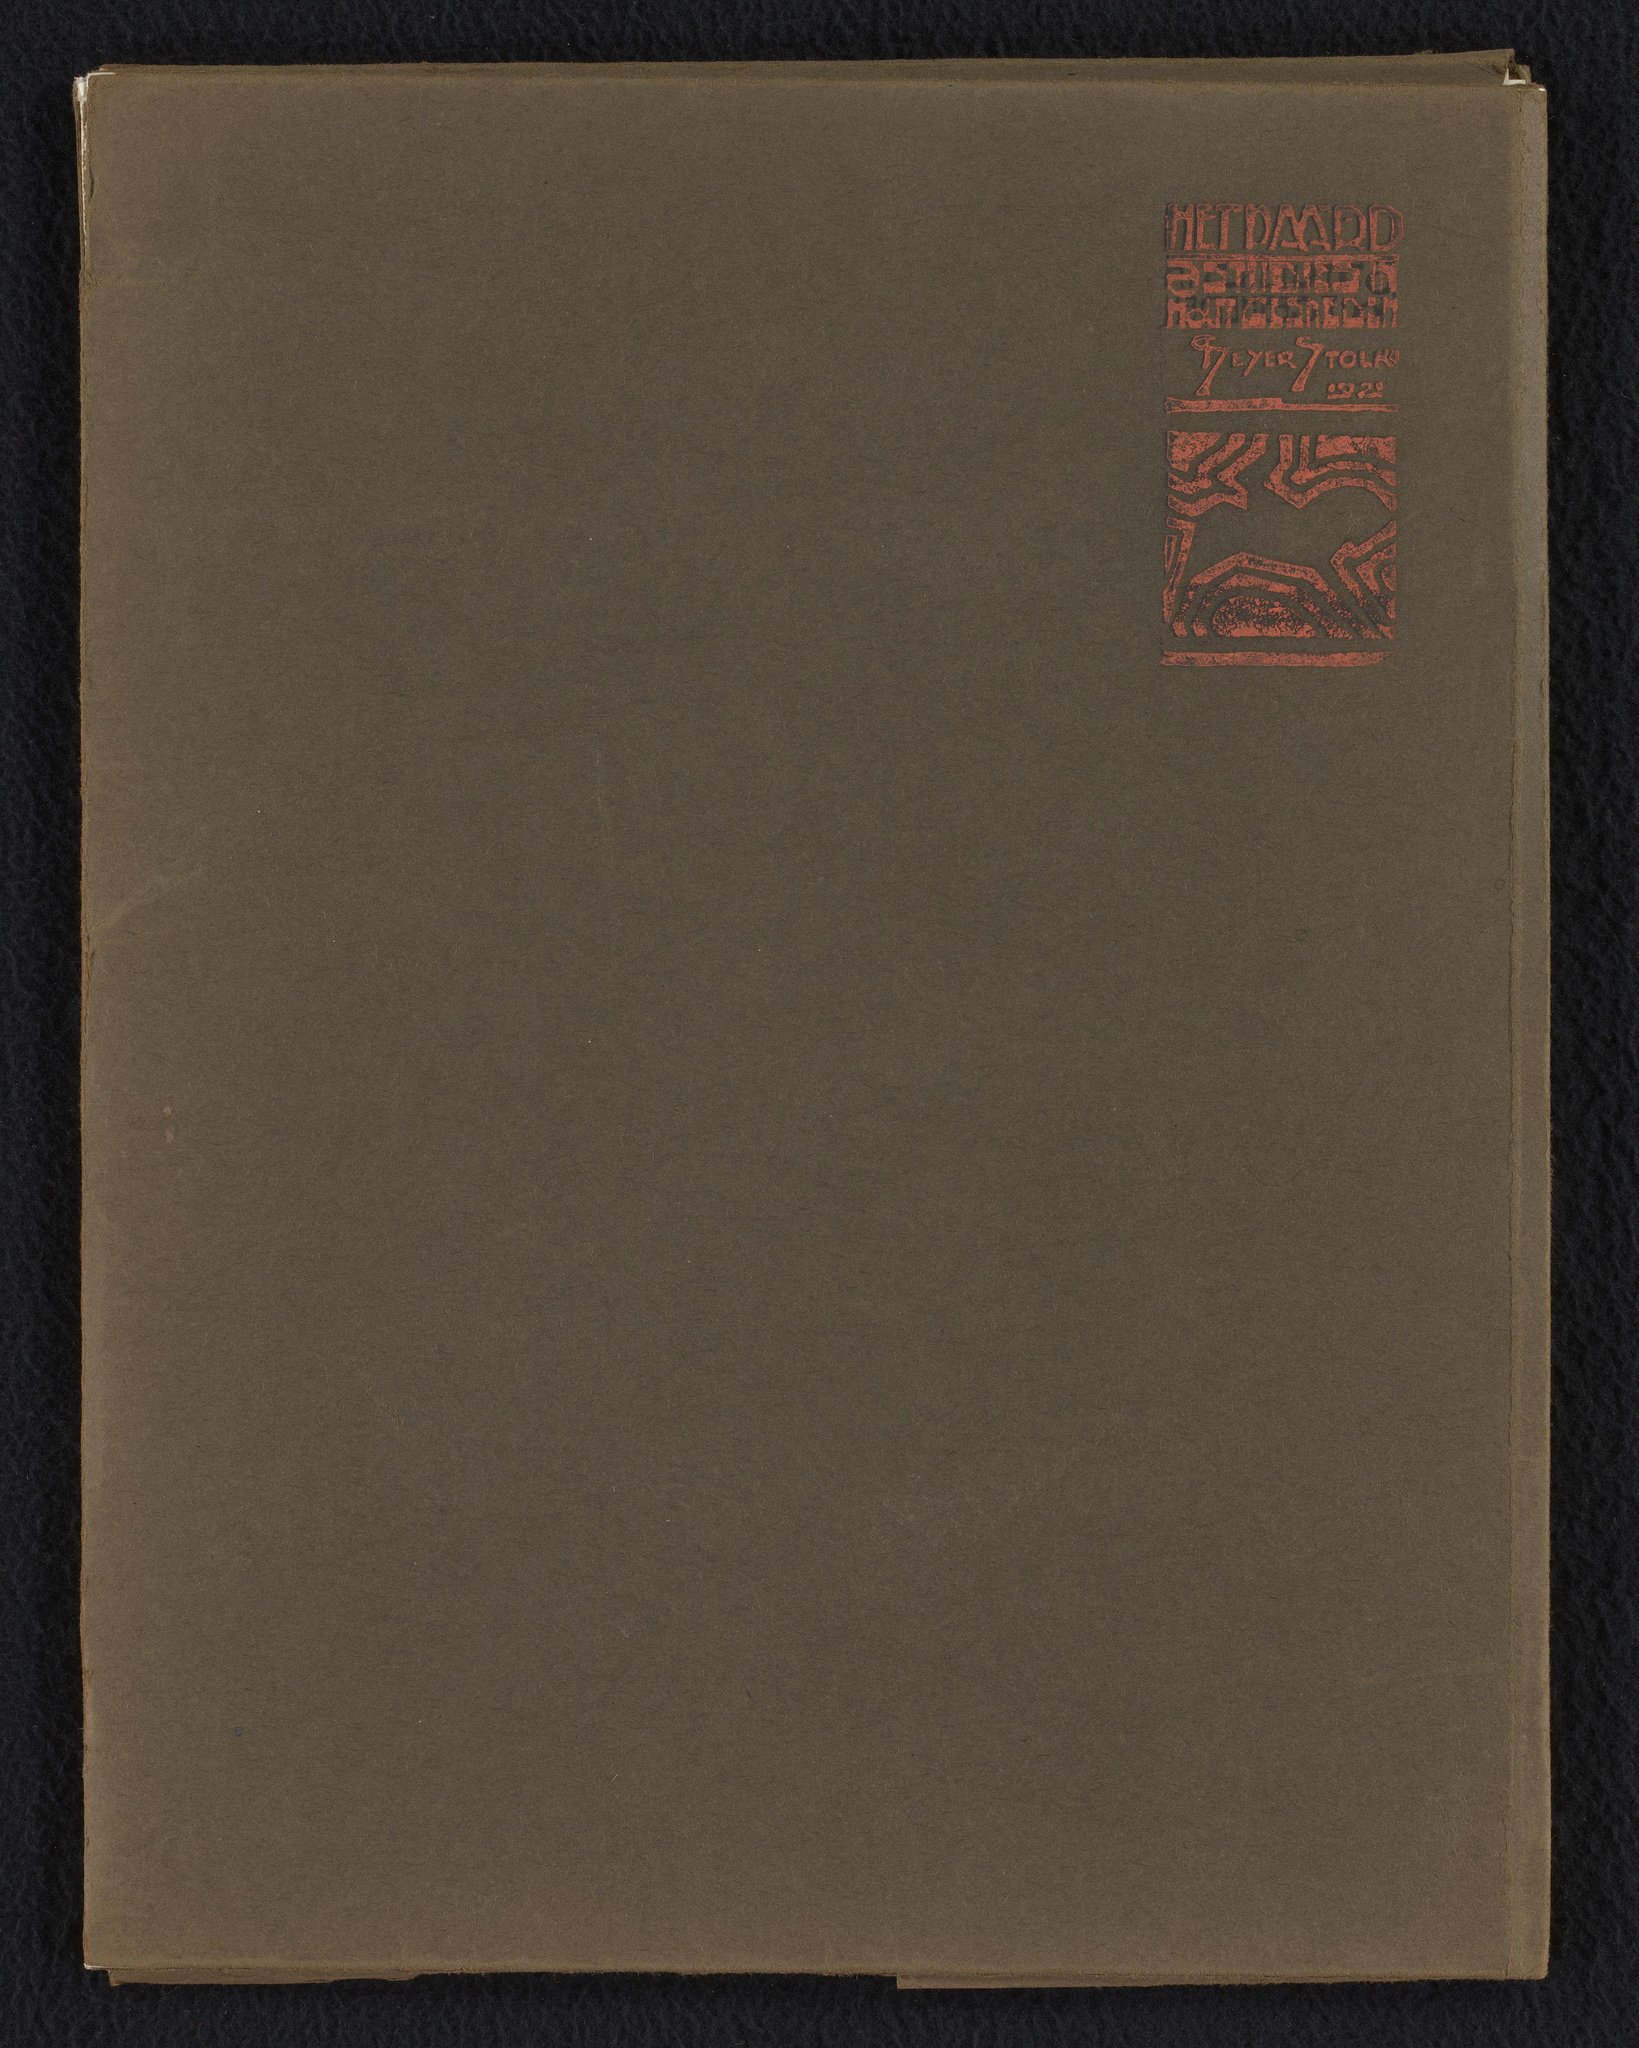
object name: wrapper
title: Omslag voor de serie 'Het Paard'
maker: reijer stolk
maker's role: draughtsman, print maker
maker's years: 1896-1945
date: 1921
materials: paper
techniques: woodcut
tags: horse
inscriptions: date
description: Omslag met een inhoudsopgave en zes prenten.